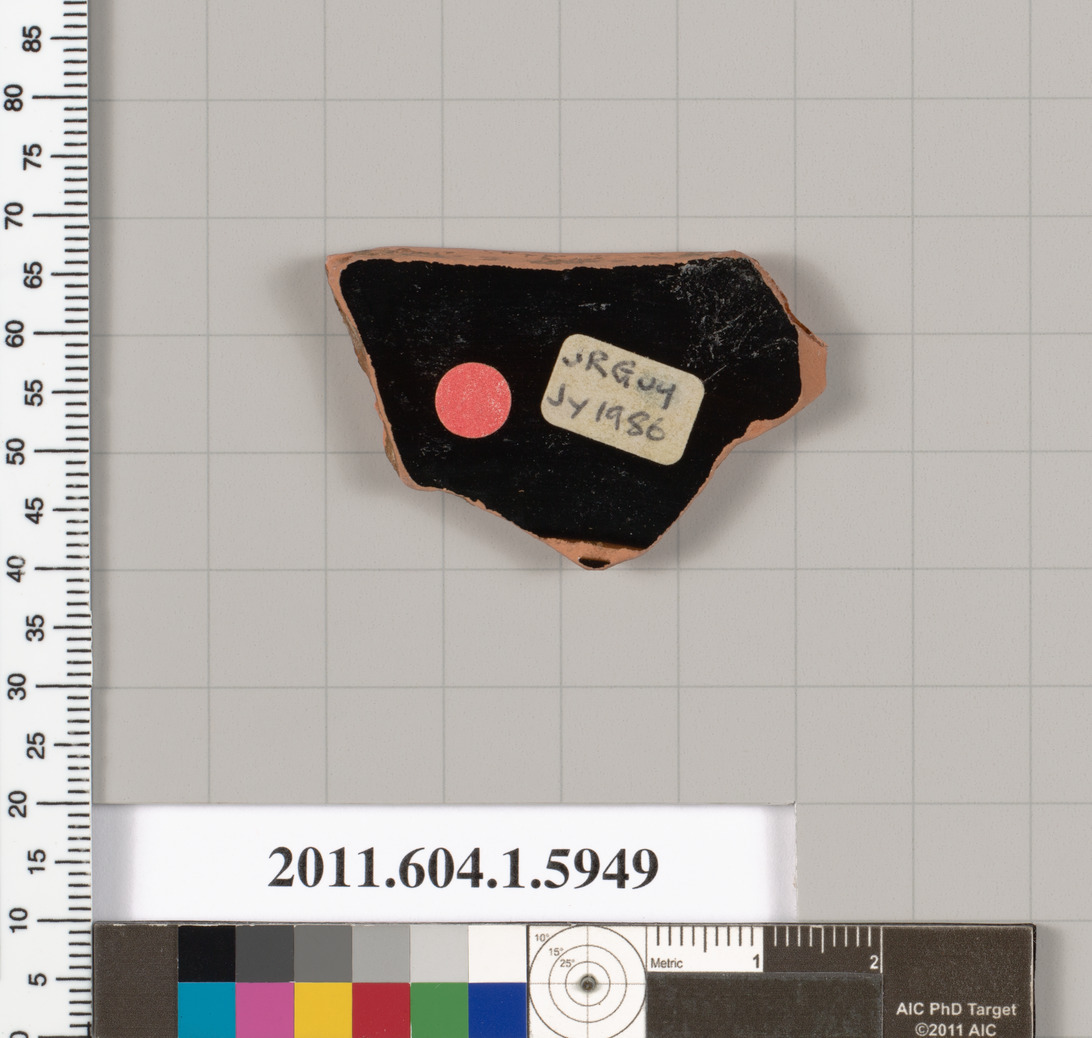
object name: kylix fragment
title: Terracotta fragment of a kylix (drinking cup)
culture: greek, attic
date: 433-567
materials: terracotta